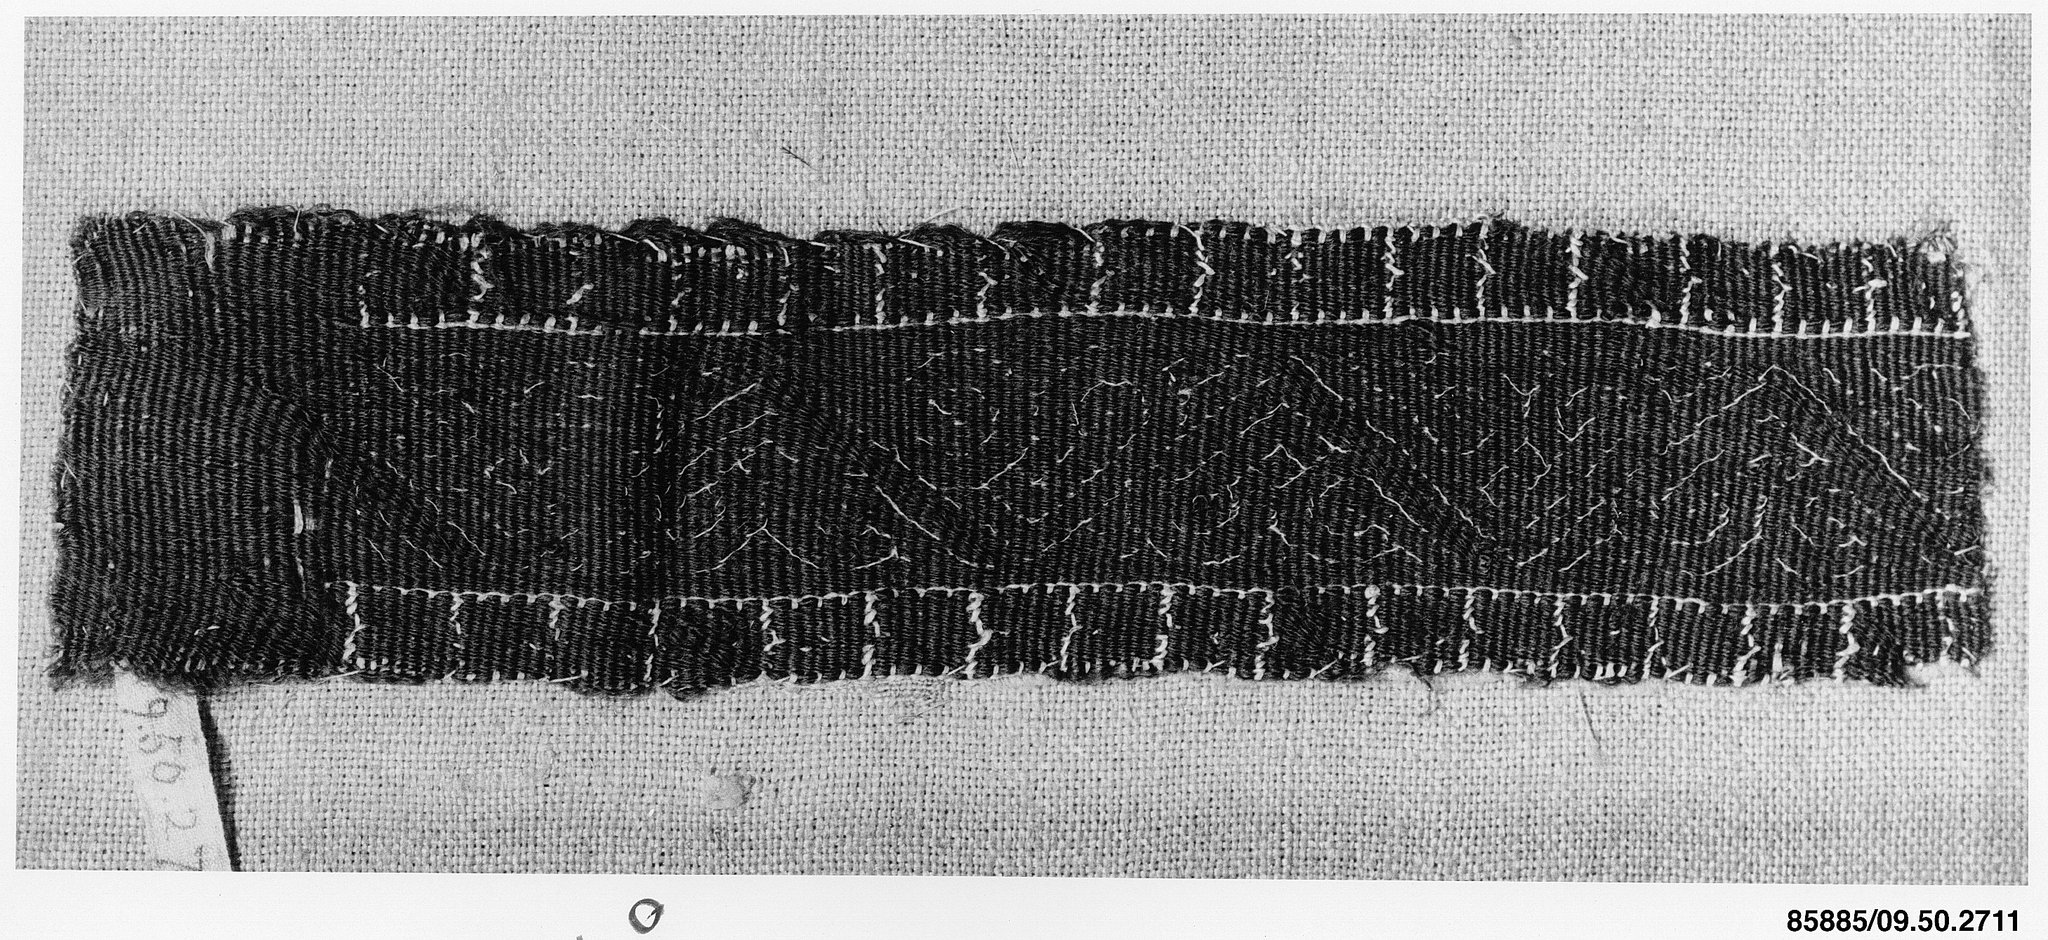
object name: band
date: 301-500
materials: linen, wool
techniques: weave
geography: egypt